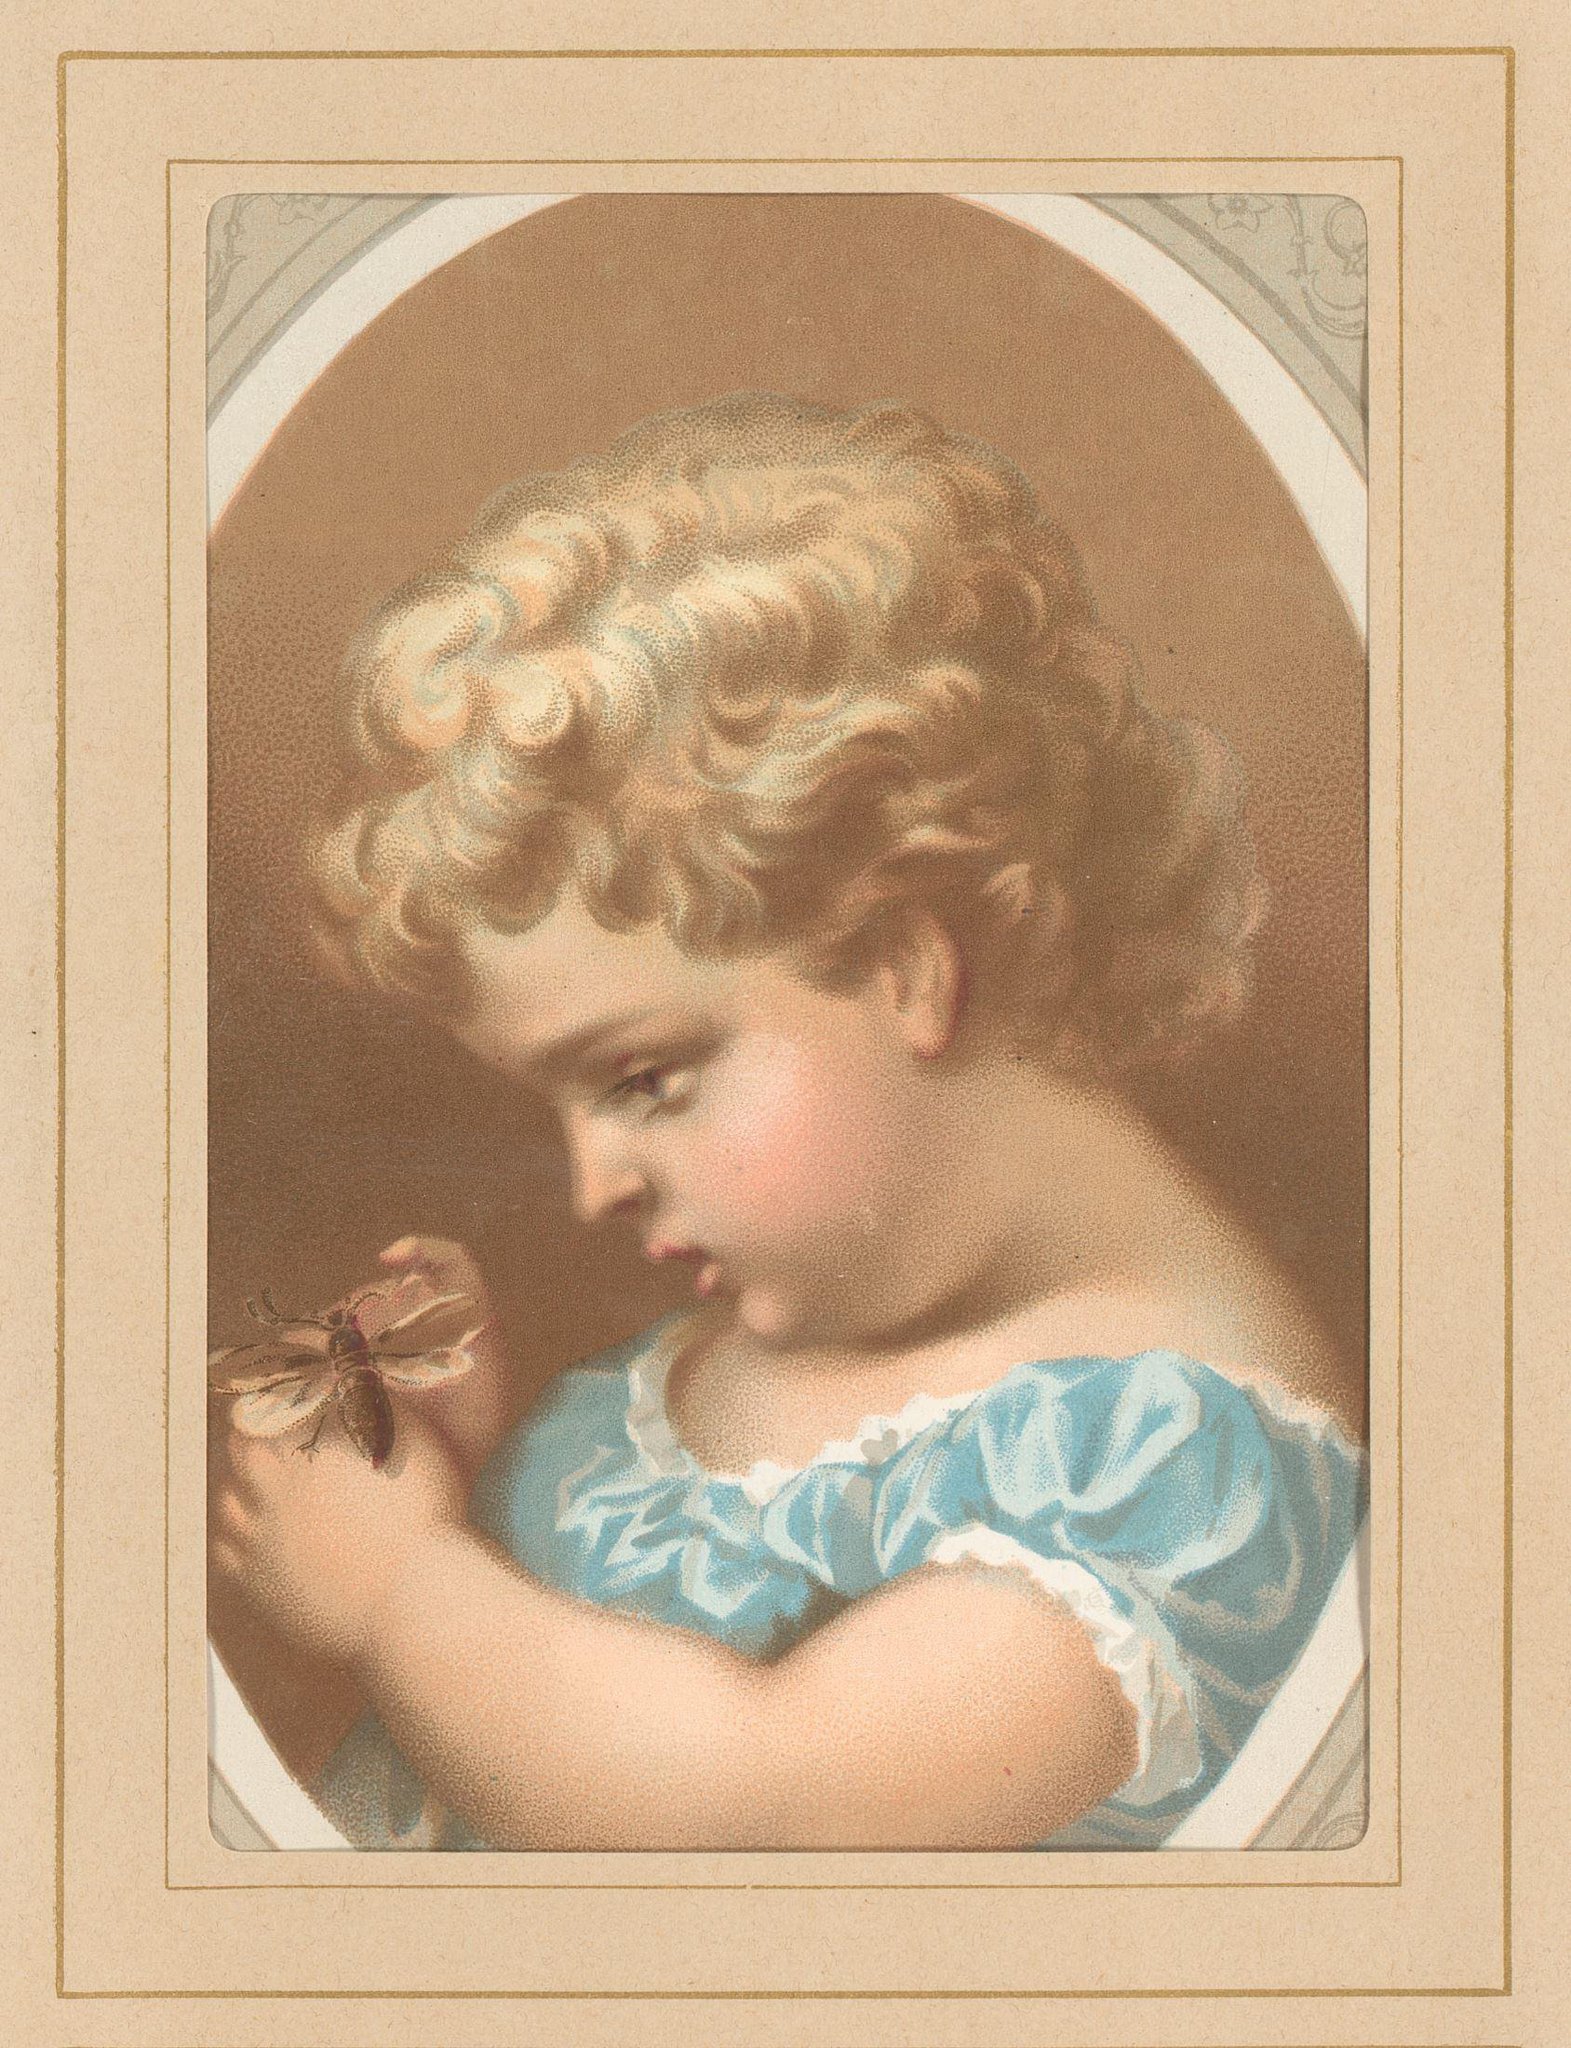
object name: photomechanical print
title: Portret van een kind met insect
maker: Anonymous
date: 1870-1900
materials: paper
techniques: collotype process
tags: child, insects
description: Deze prent maakt deel uit van een album.